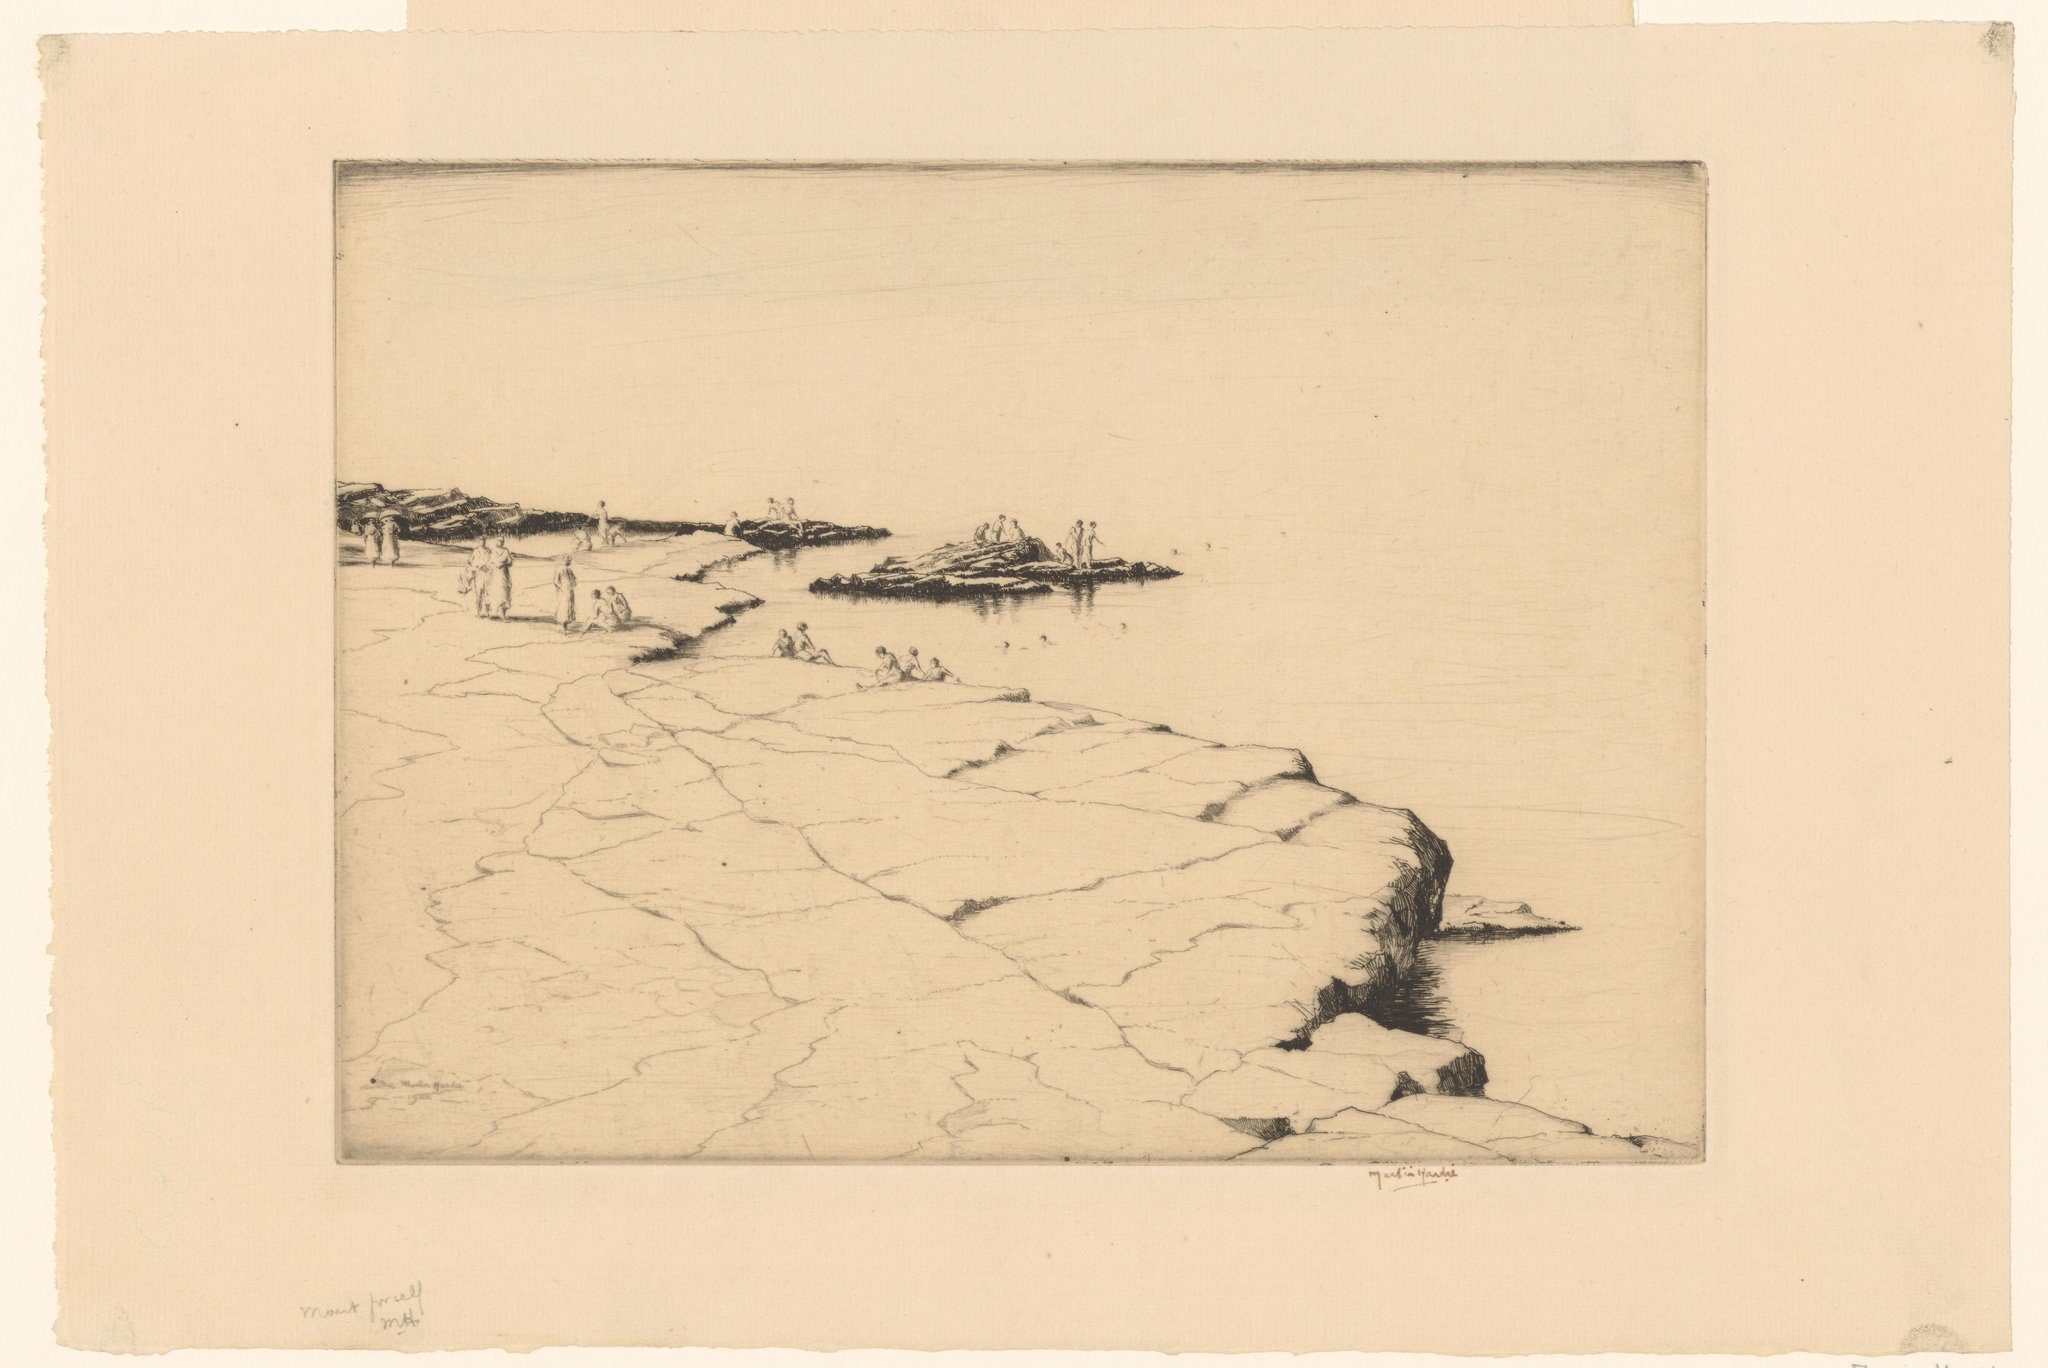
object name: print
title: The Bathing Place, Bordighera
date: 1922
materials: paper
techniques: etching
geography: bordighera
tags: recreation, bathing (movement in water)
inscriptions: collector's mark: Lugt 2228, collector's mark: Lugt 2760, annotation: ‘Martin Hardie’